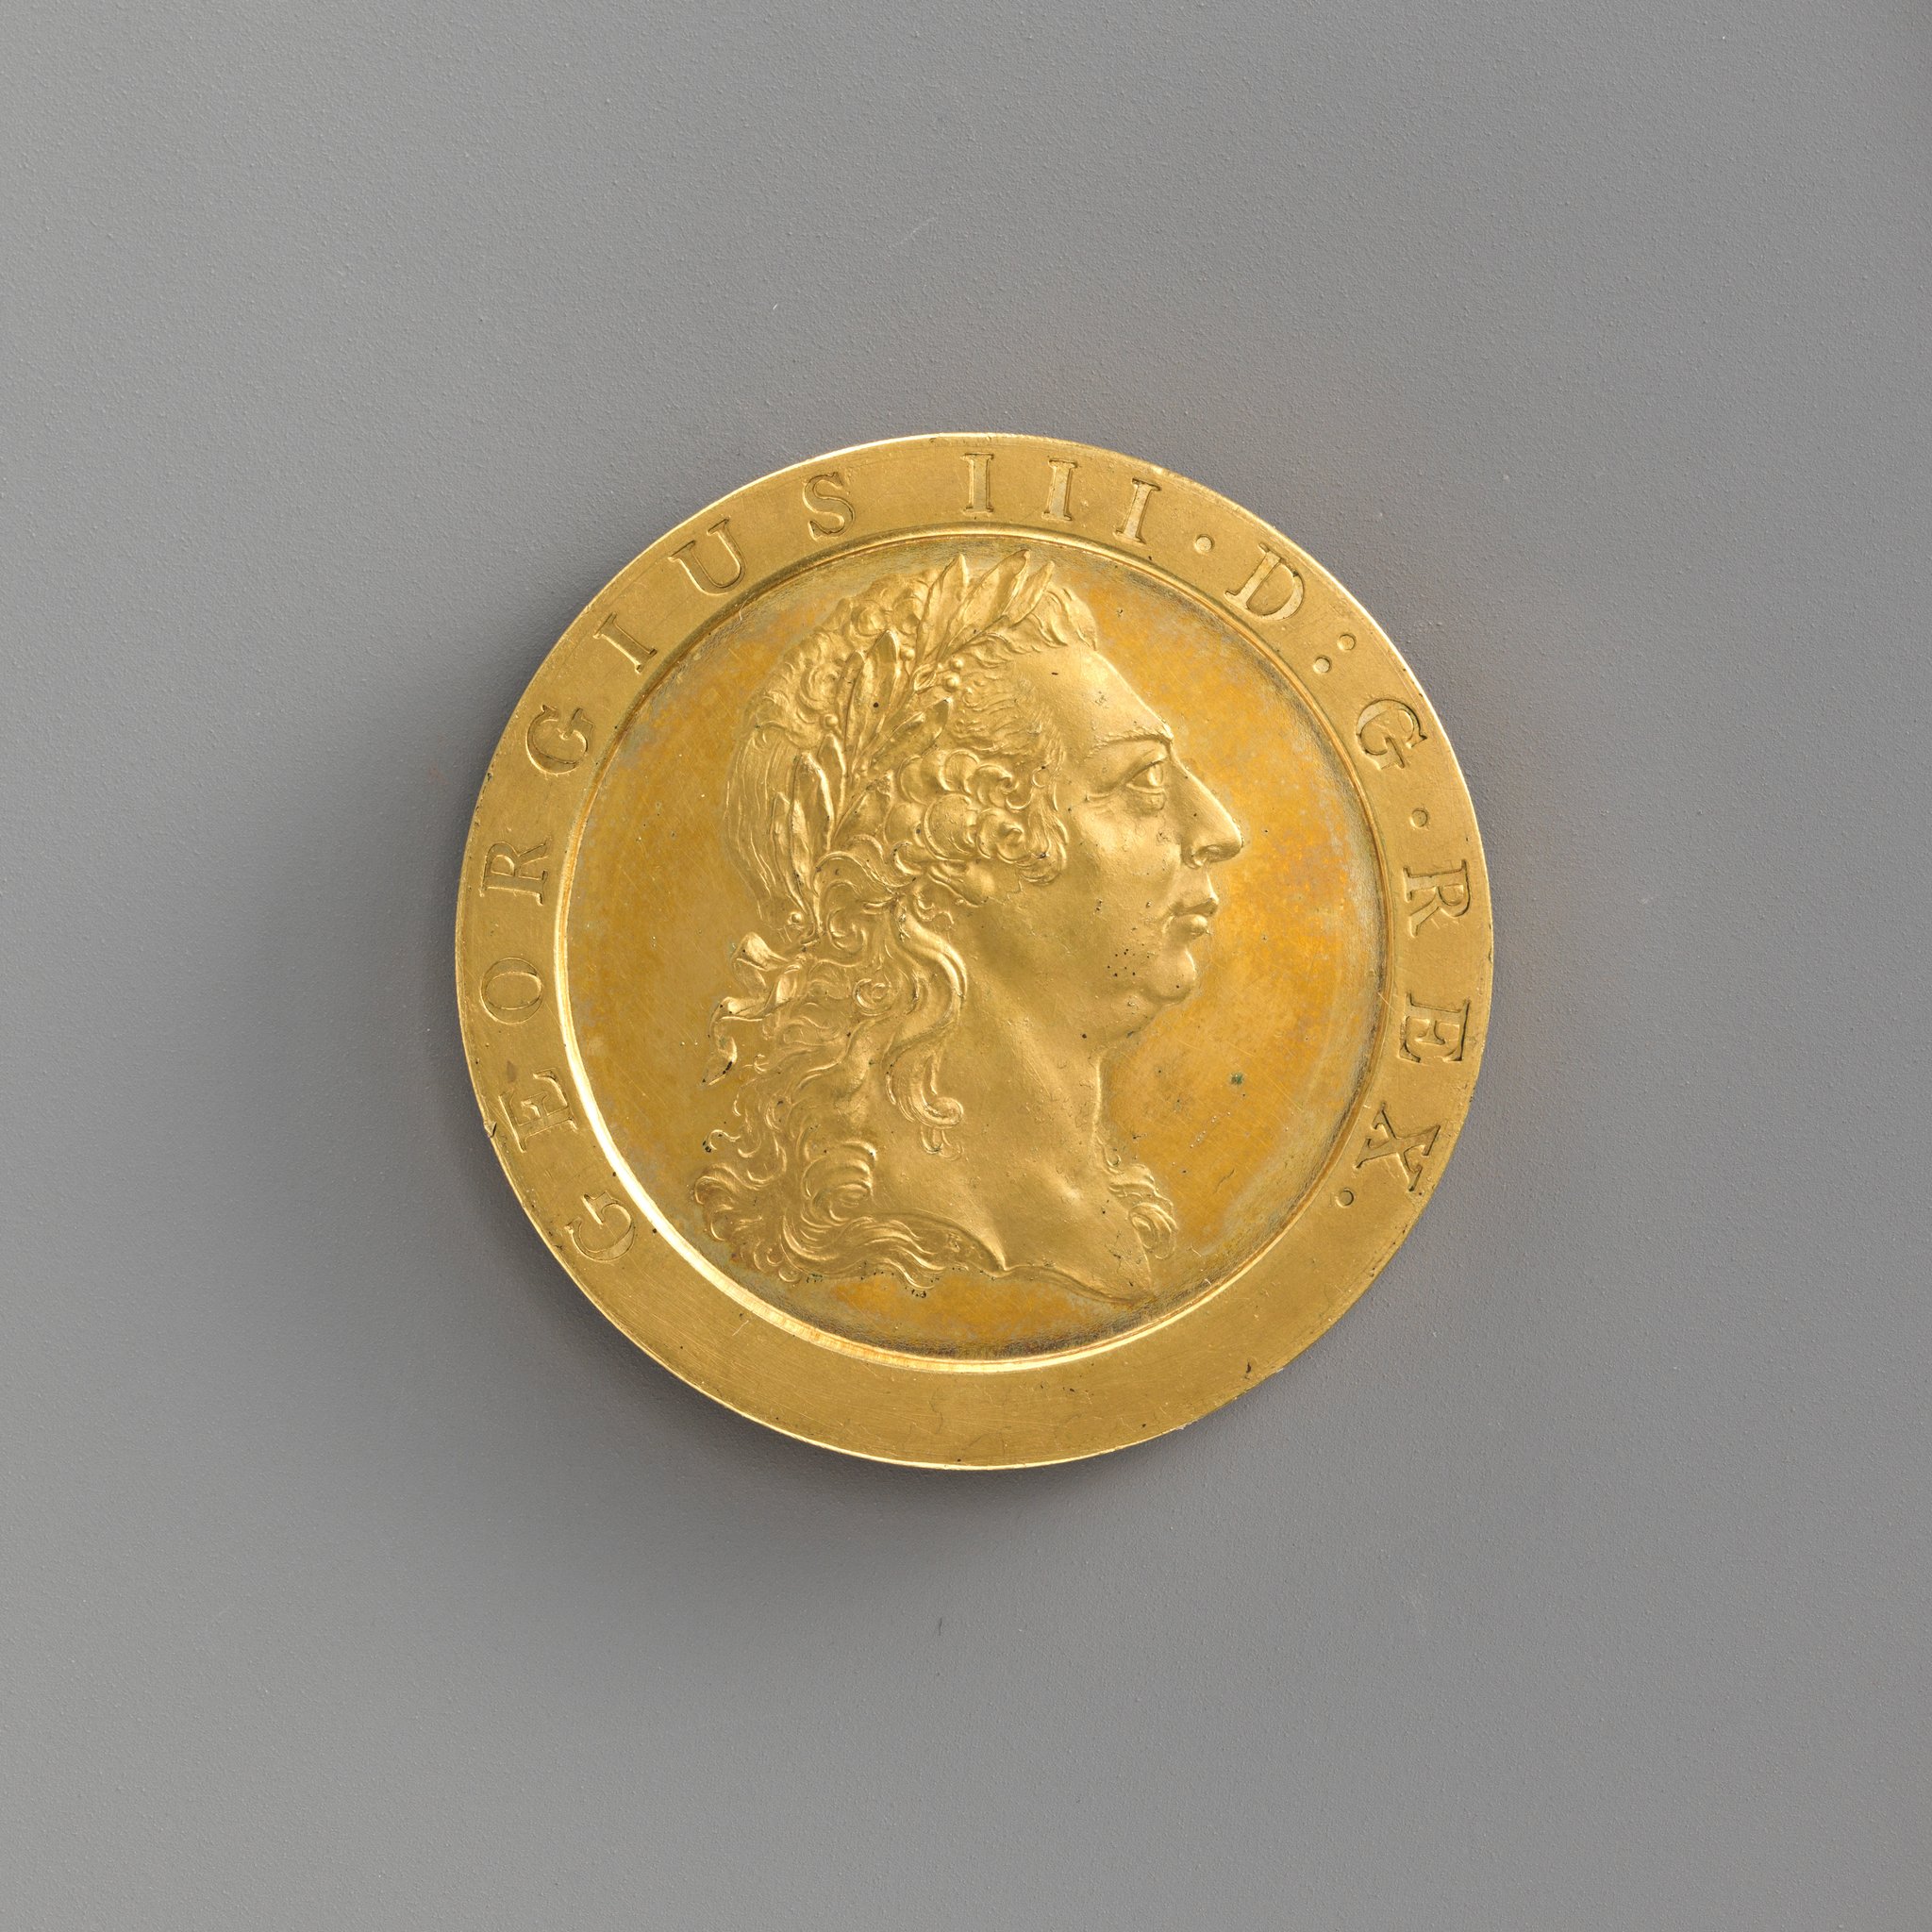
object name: penny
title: Pattern penny of George III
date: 1797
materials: copper gilt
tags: men,profiles,women,coins